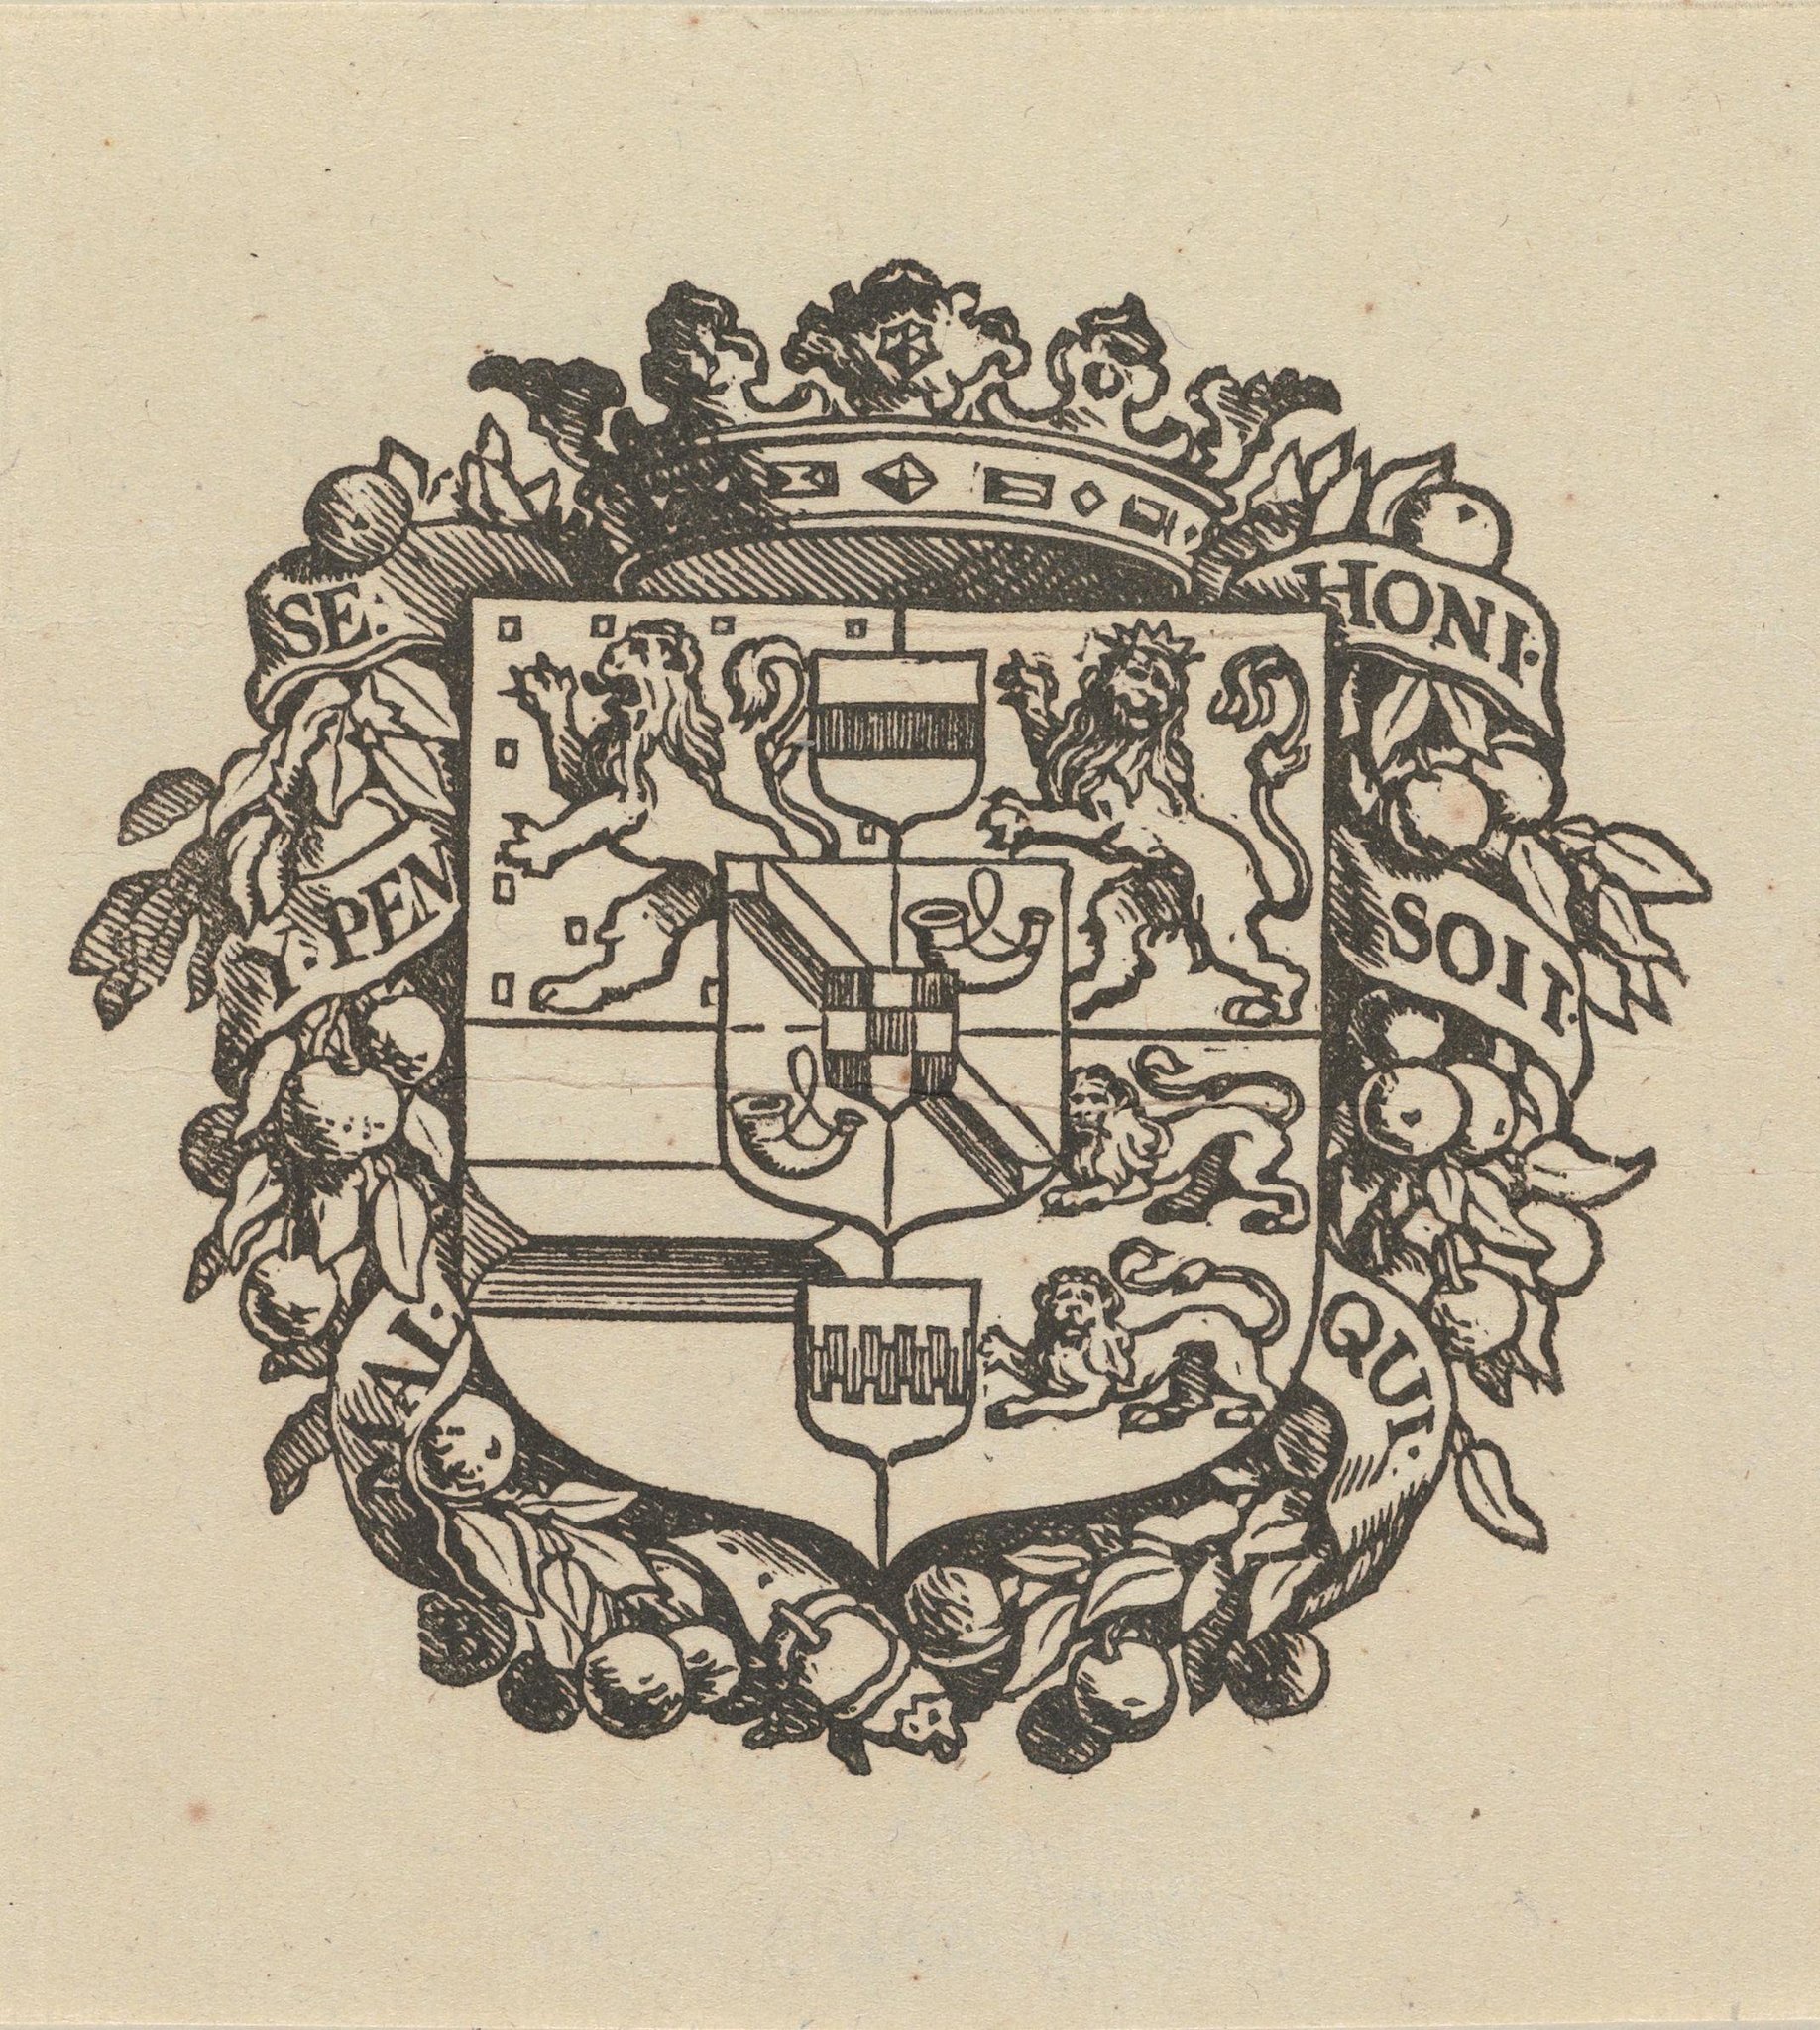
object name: print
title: Wapen van het Huis Nassau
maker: dirck de bray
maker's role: draughtsman, painter, print maker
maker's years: 1625-1694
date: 1635-1694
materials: paper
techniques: woodcut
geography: netherlands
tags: armorial bearing, heraldry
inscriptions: collector's mark: Lugt 2228